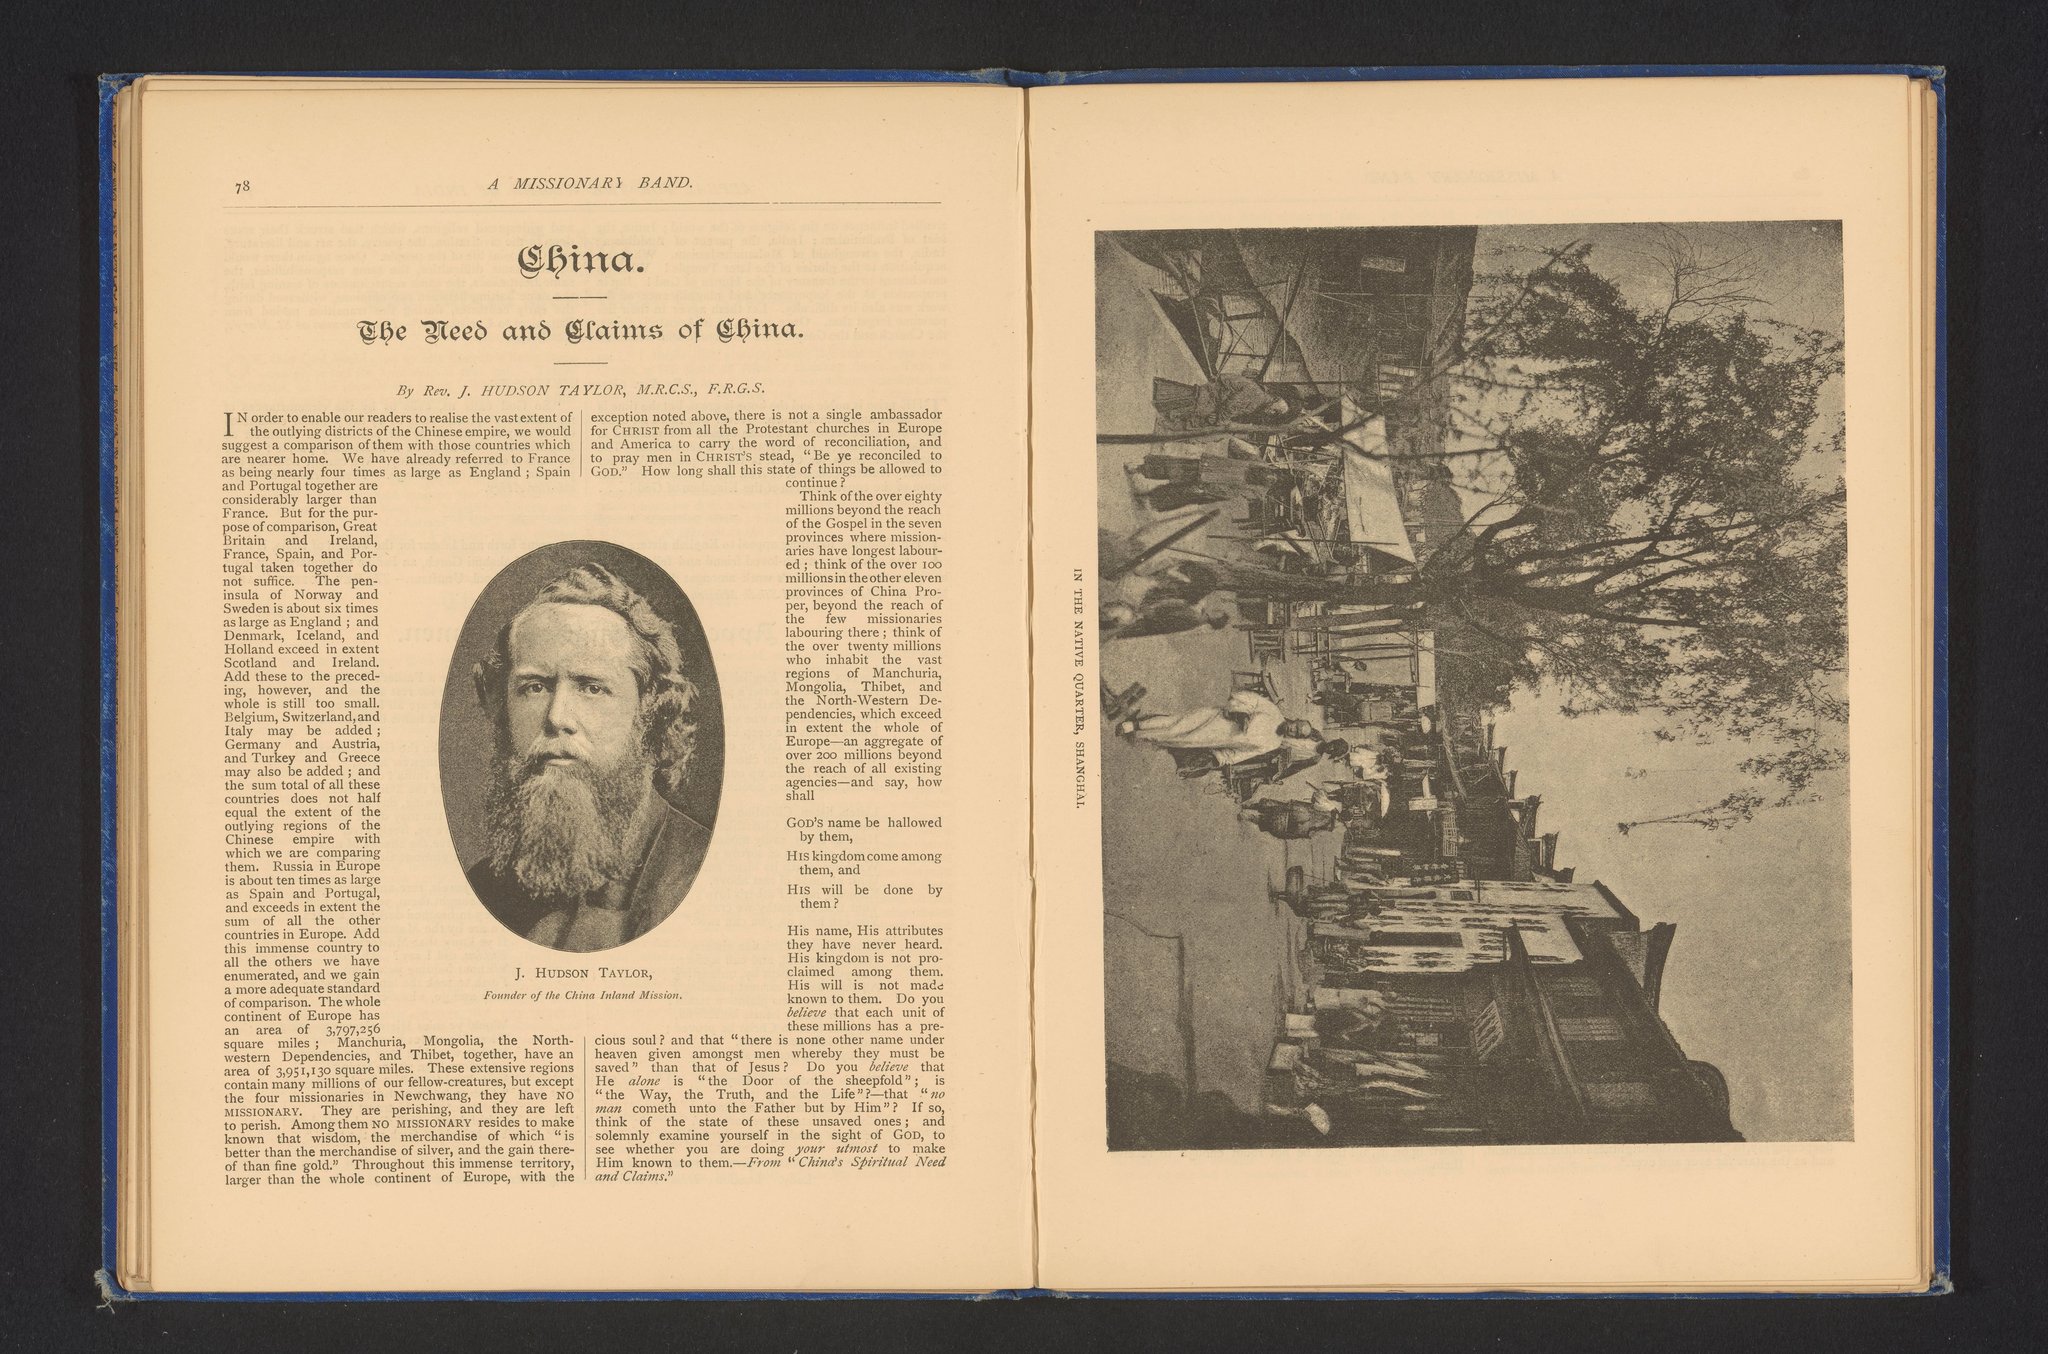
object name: photomechanical print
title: J. Hudson Taylor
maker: Anonymous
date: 1881-1886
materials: paper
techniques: autotype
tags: missionary, historical persons, spreading the gospel; missionary work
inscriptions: inscription: ‘Founder of the China Inland Mission.’